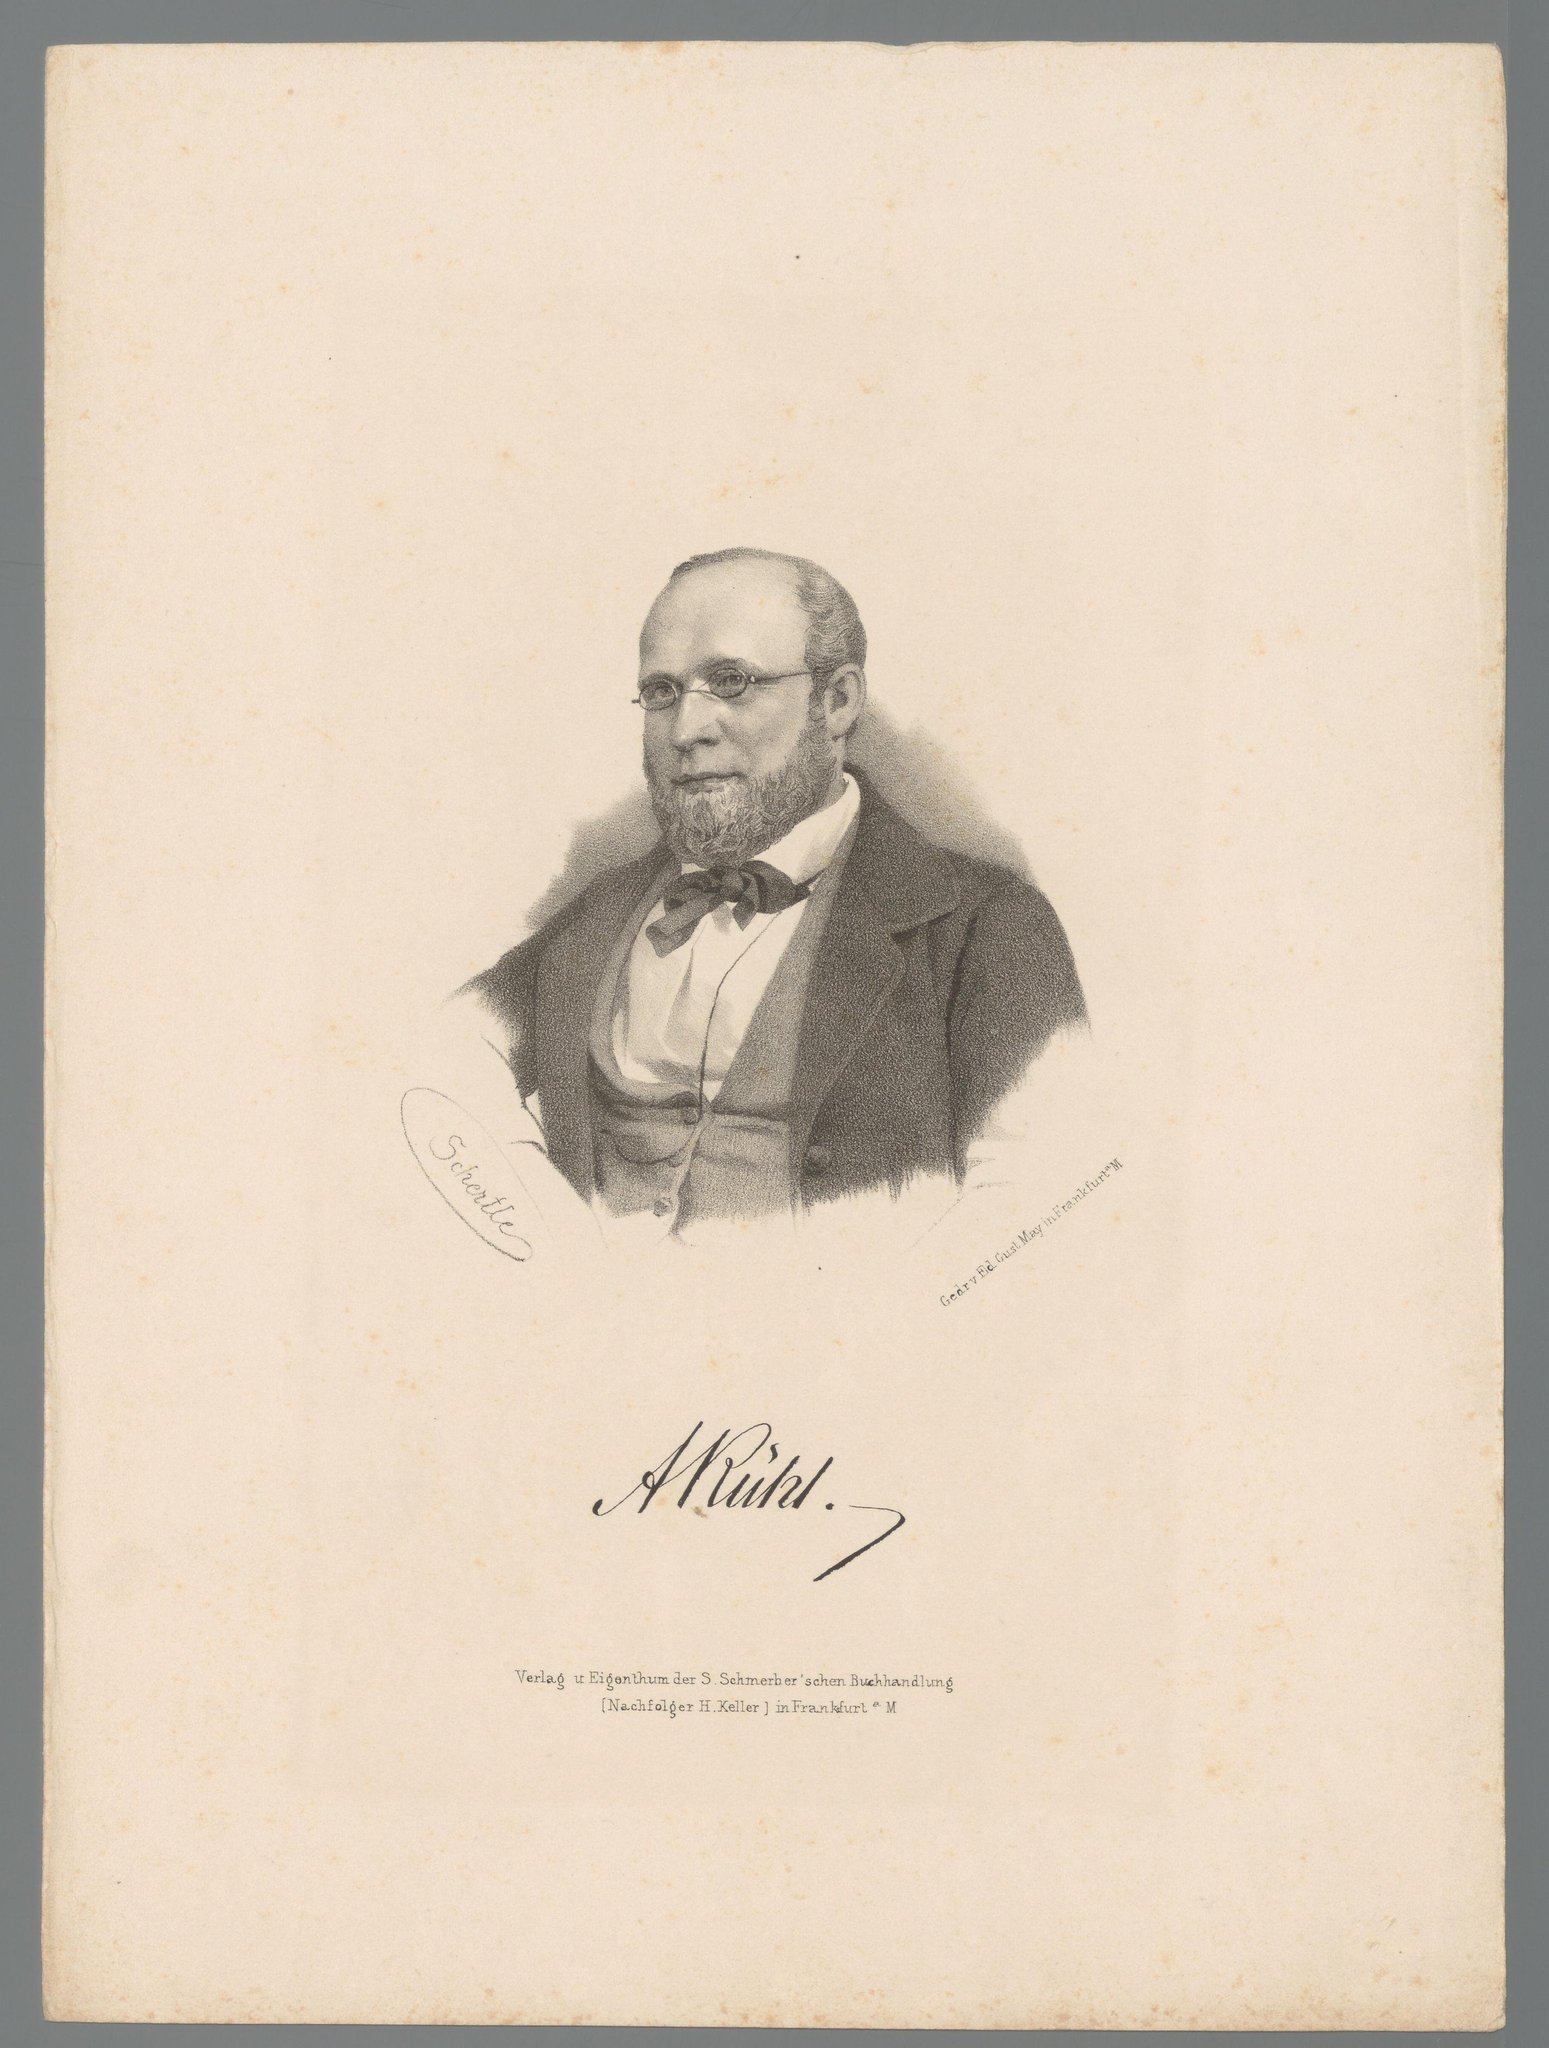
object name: print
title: Portretten van Duitse mannen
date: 1848-1849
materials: paper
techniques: lithograph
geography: frankfurt am main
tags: eyeglasses, spectacles, adult man, historical persons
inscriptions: collector's mark: Lugt 2228